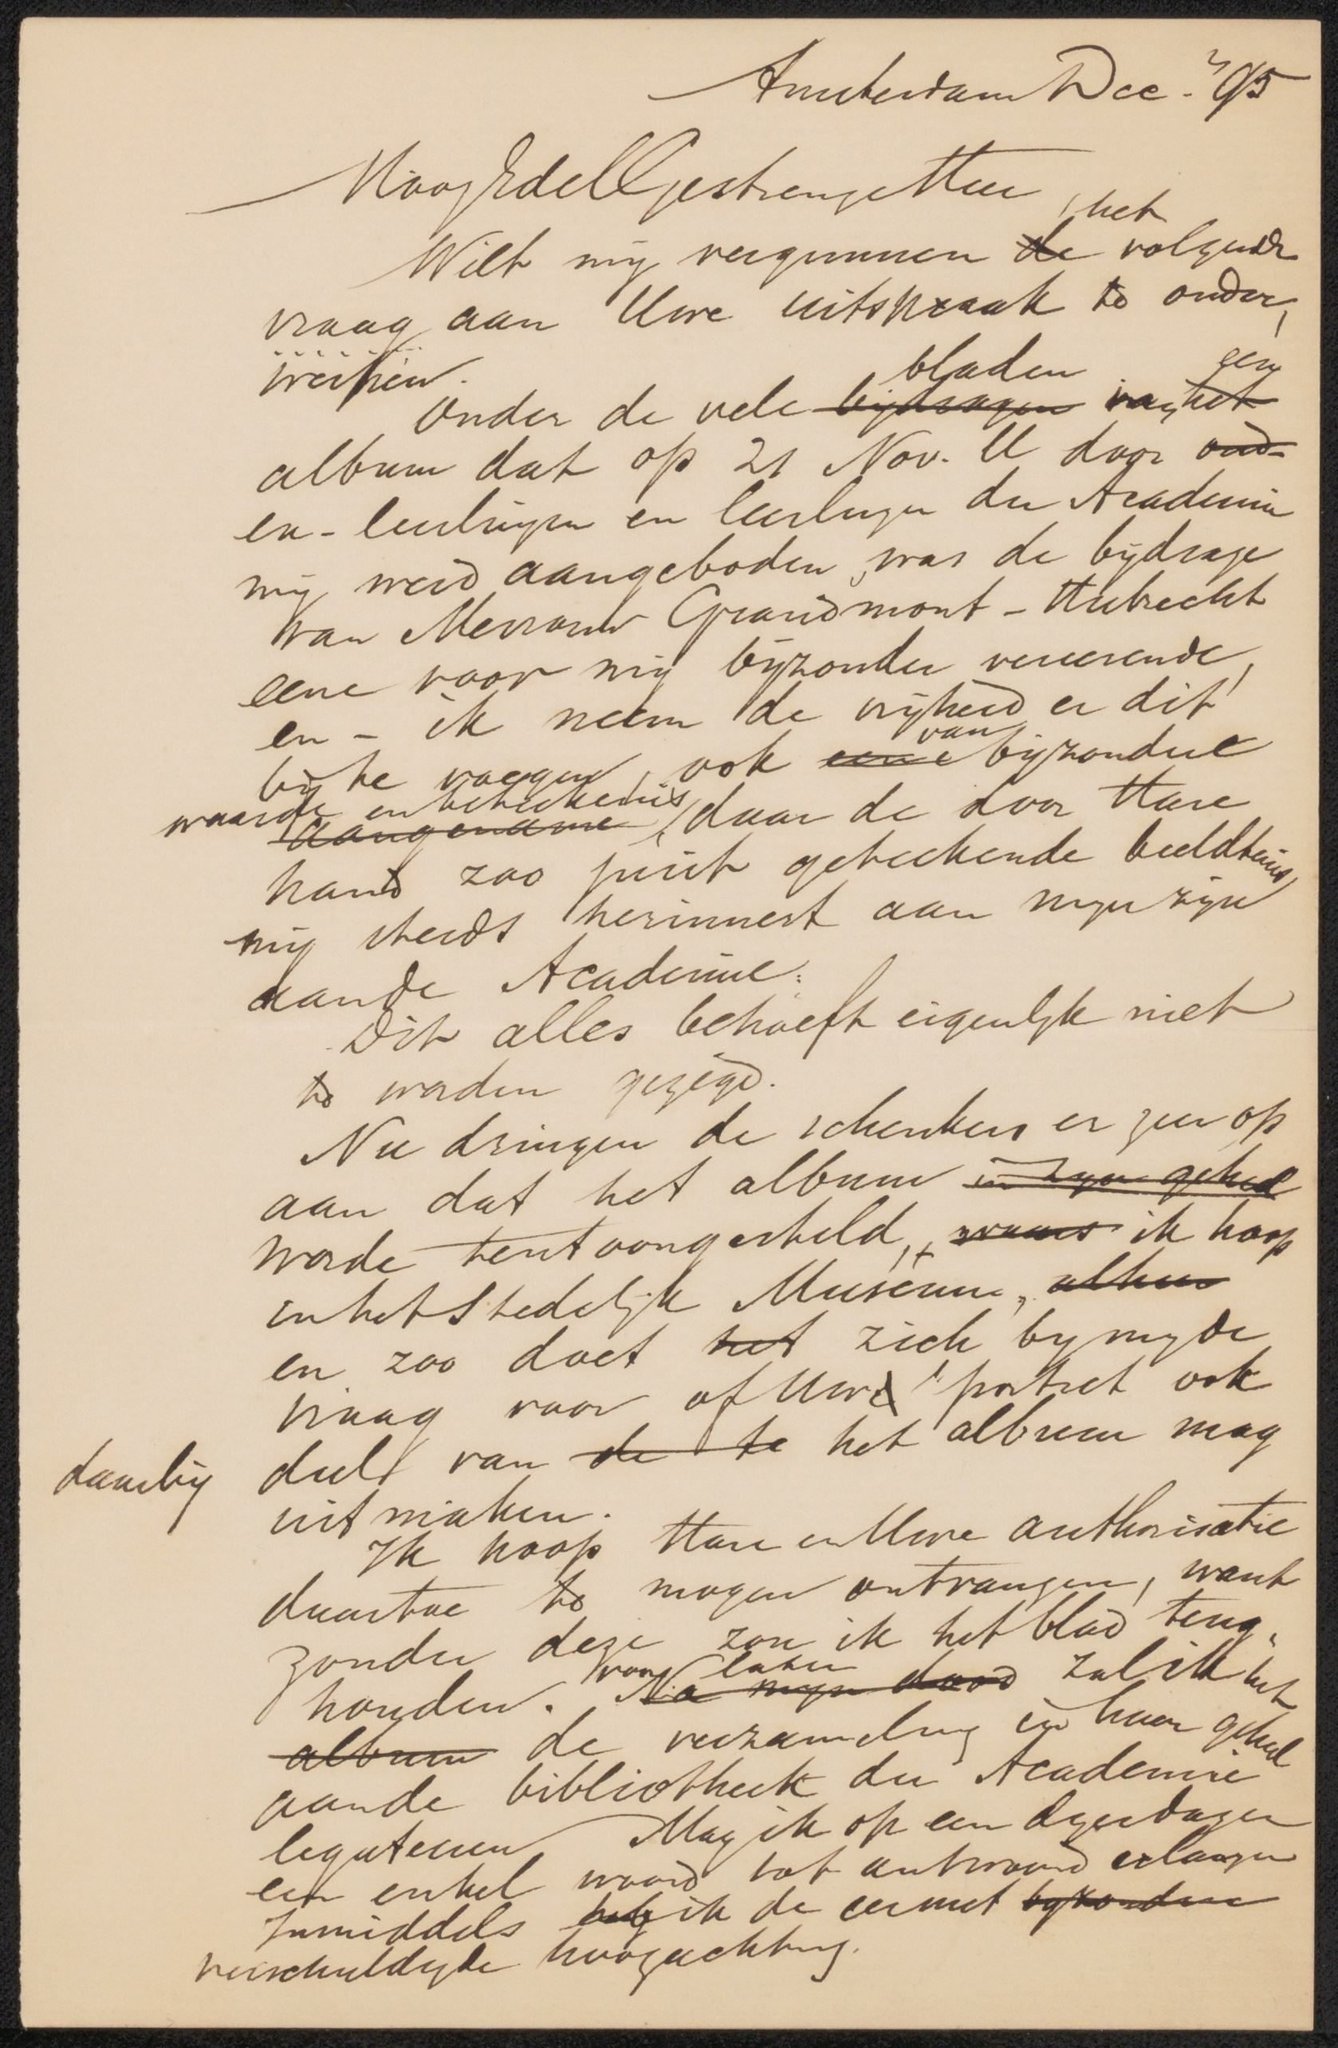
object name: letter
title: Conceptbrief aan anoniem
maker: august allebé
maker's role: draughtsman, print maker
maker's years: 1838-1927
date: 1812-1895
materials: ink, paper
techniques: pen, writing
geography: amsterdam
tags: rotterdam, painter, print maker, draughtsman, bramine hubrecht, drawing, exhibition ~ art, historical persons (portraits and scenes from the life)